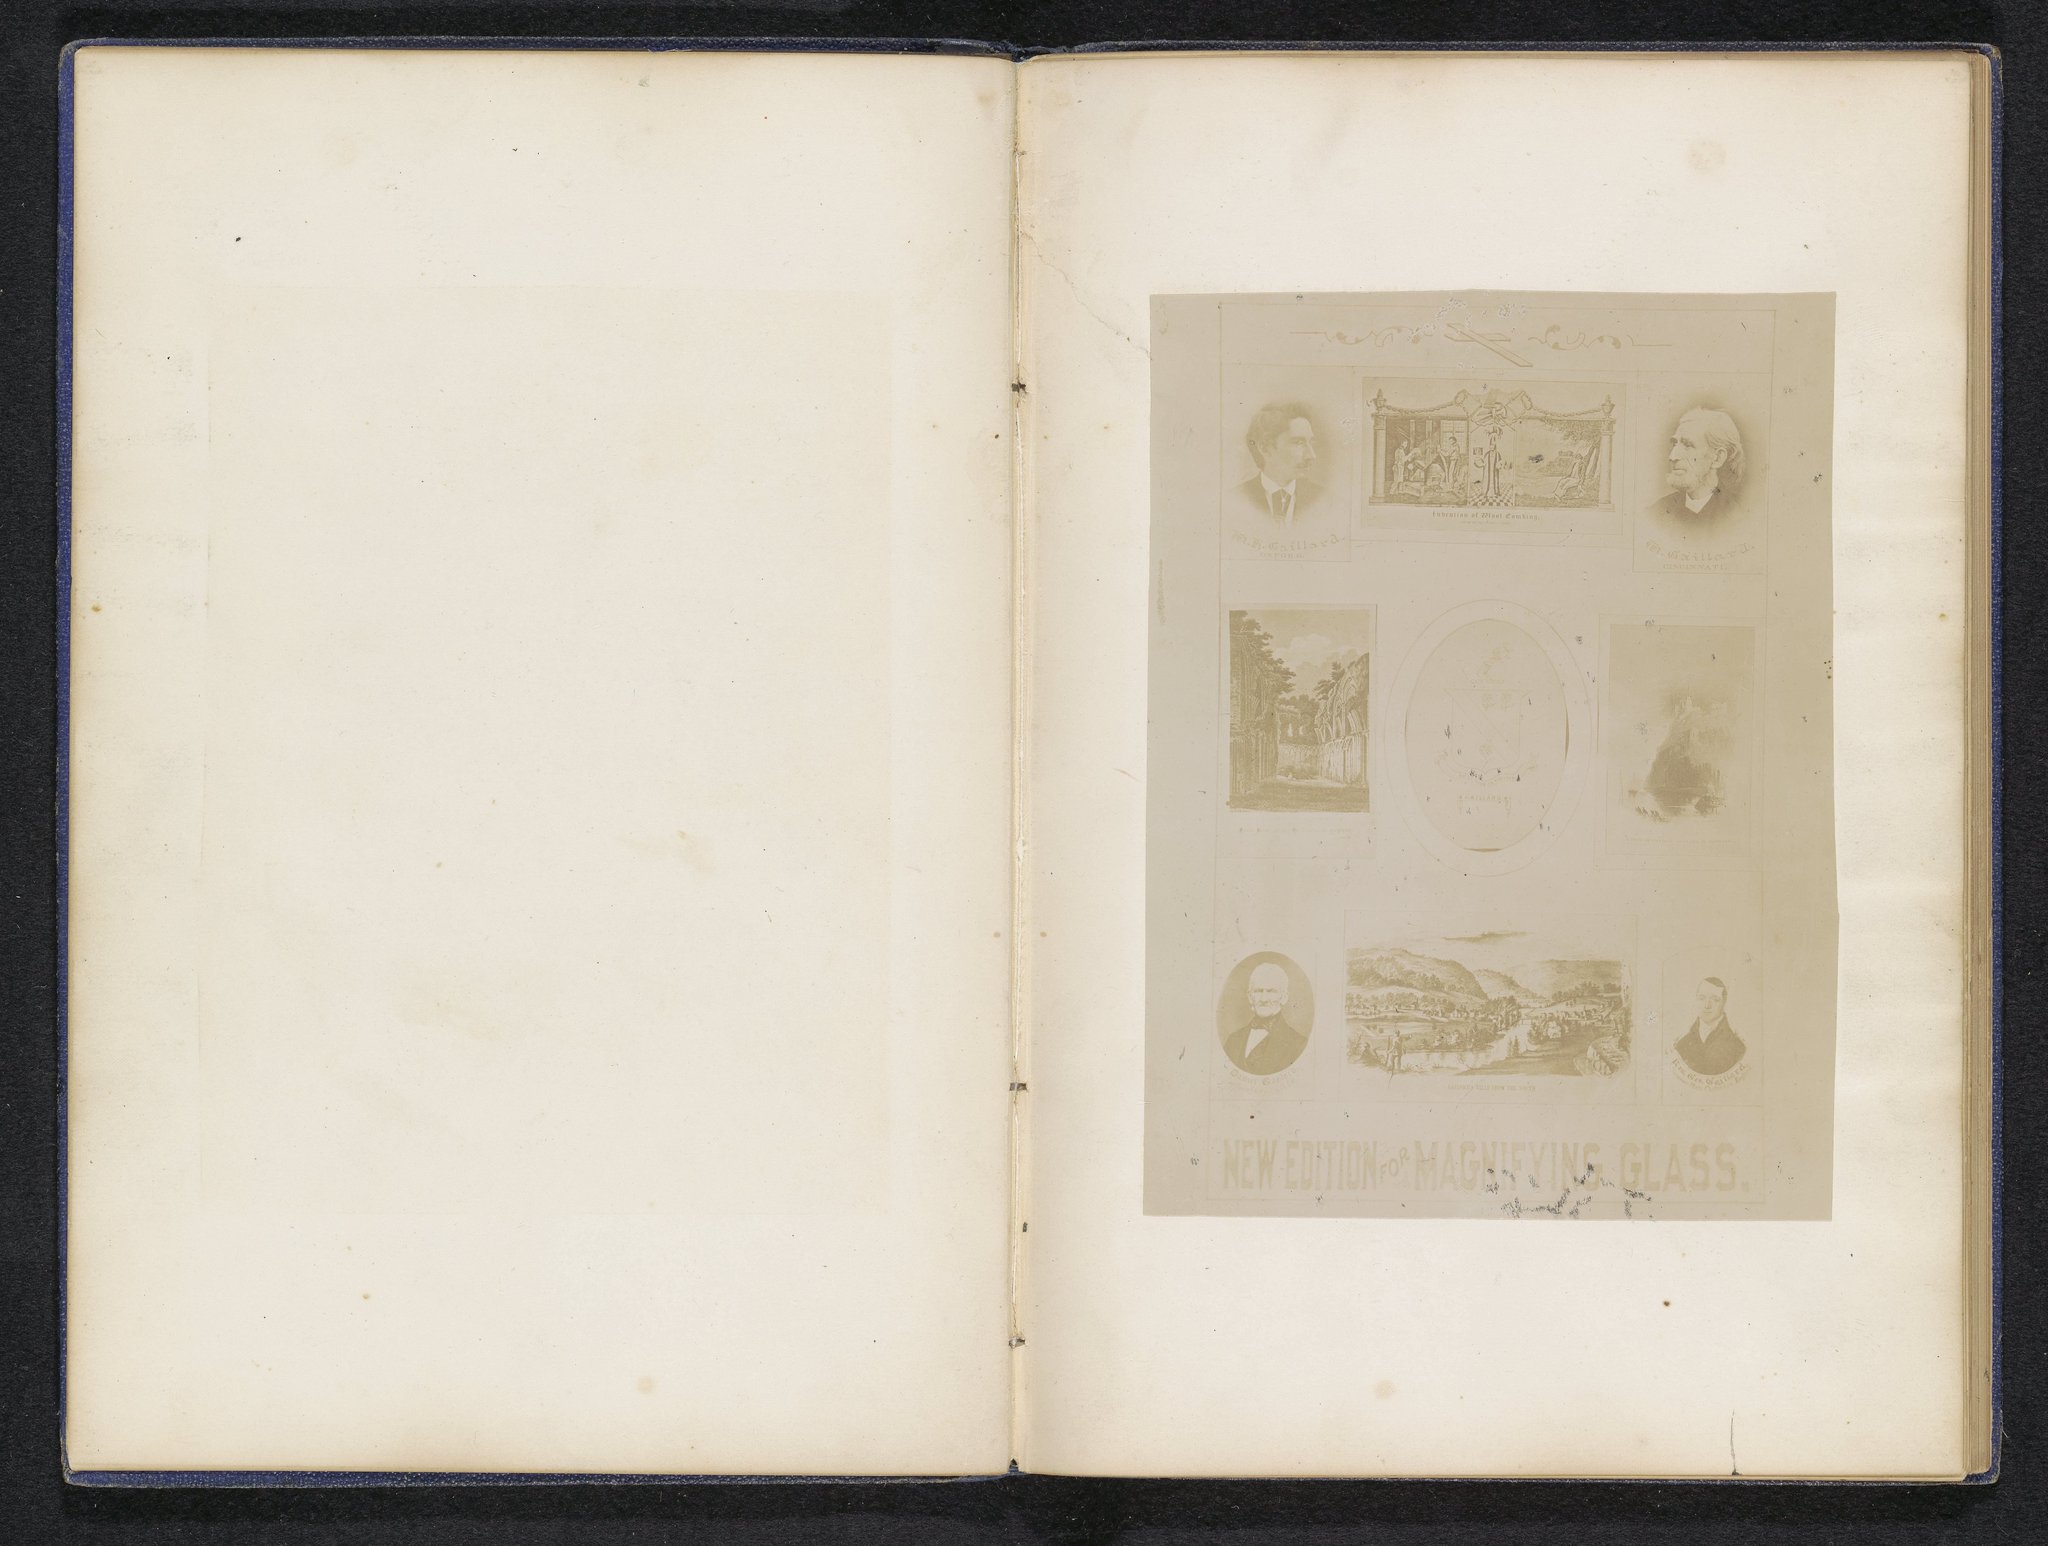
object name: page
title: Fotoreproductie van een fotocollage met portretten van leden van de familie Gaillard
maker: Anonymous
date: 1865-1870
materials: photographic support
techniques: albumen print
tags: family lineage, pedigree, genealogical tree or table